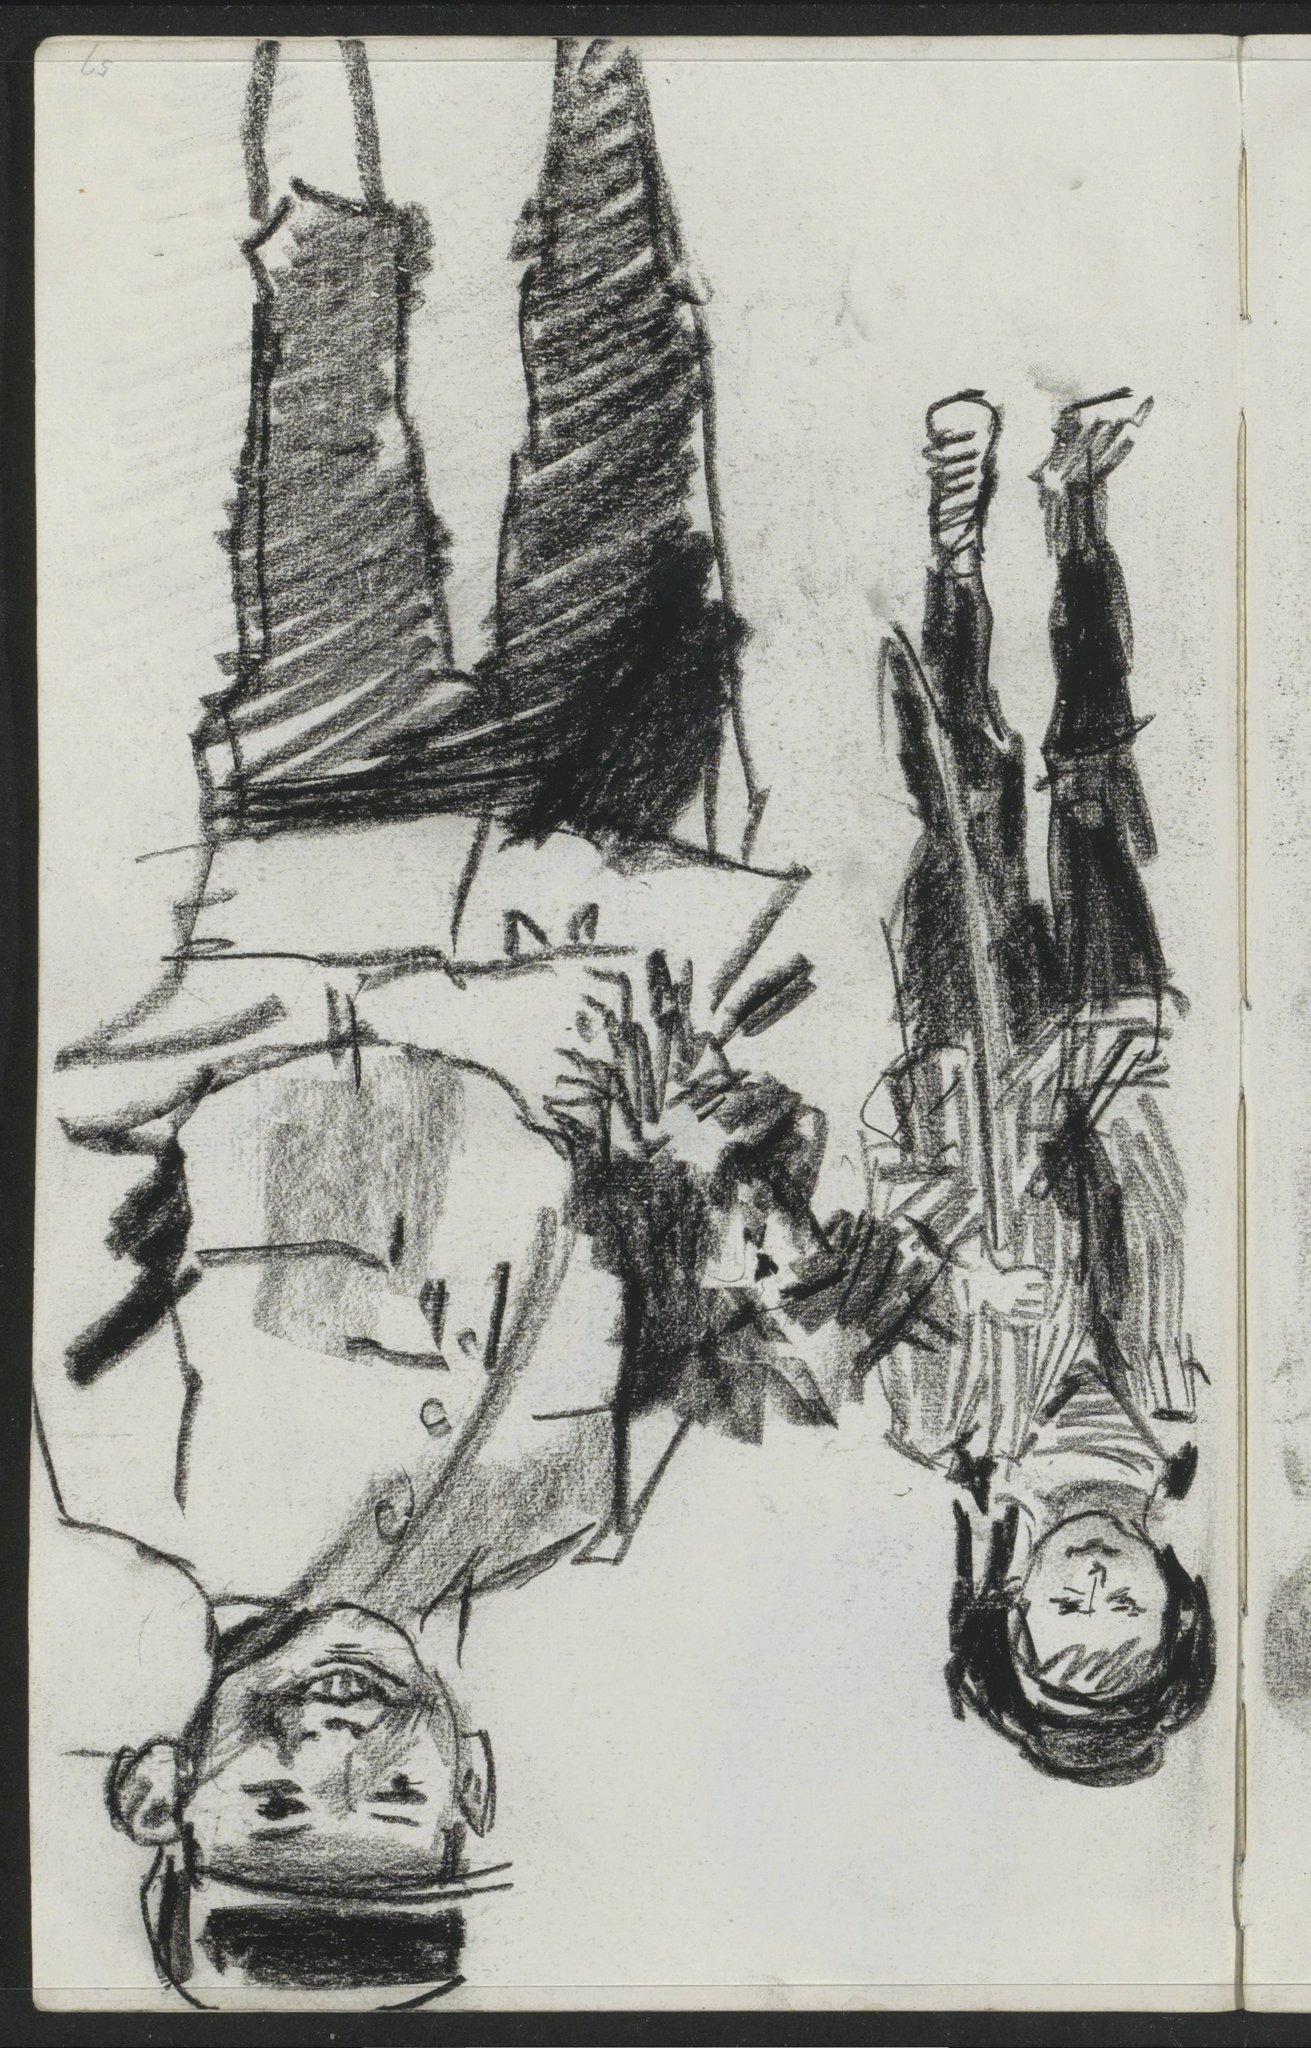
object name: sketchbook leaf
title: Twee kinderen met een hond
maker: isaac israels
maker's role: draughtsman, painter, print maker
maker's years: 1865-1934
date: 1875-1934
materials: chalk, paper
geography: amsterdam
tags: boy (child between toddler and youth), girl (child between toddler and youth), (bowling a) hoop, dog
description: Vooraan een jongen met een hond op de arm. Achter hem een meisje met een hoepel om haar schouder. Blad 4 verso uit schetsboek XI met 30 bladen.